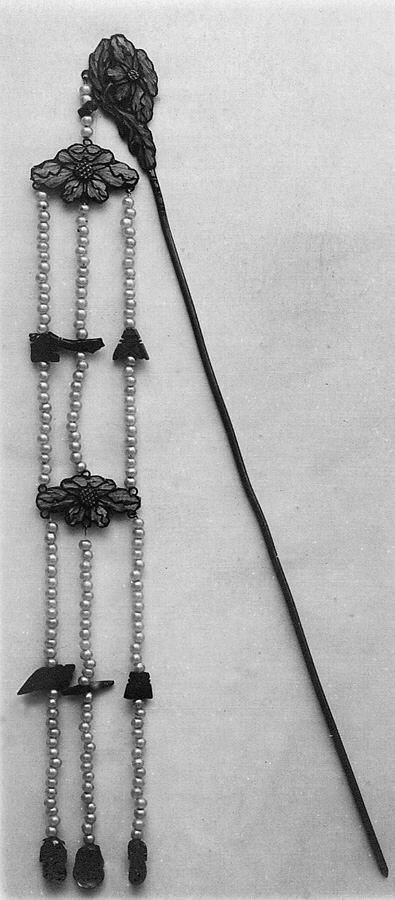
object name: hair pin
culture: chinese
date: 1701-1900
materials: gold, stone